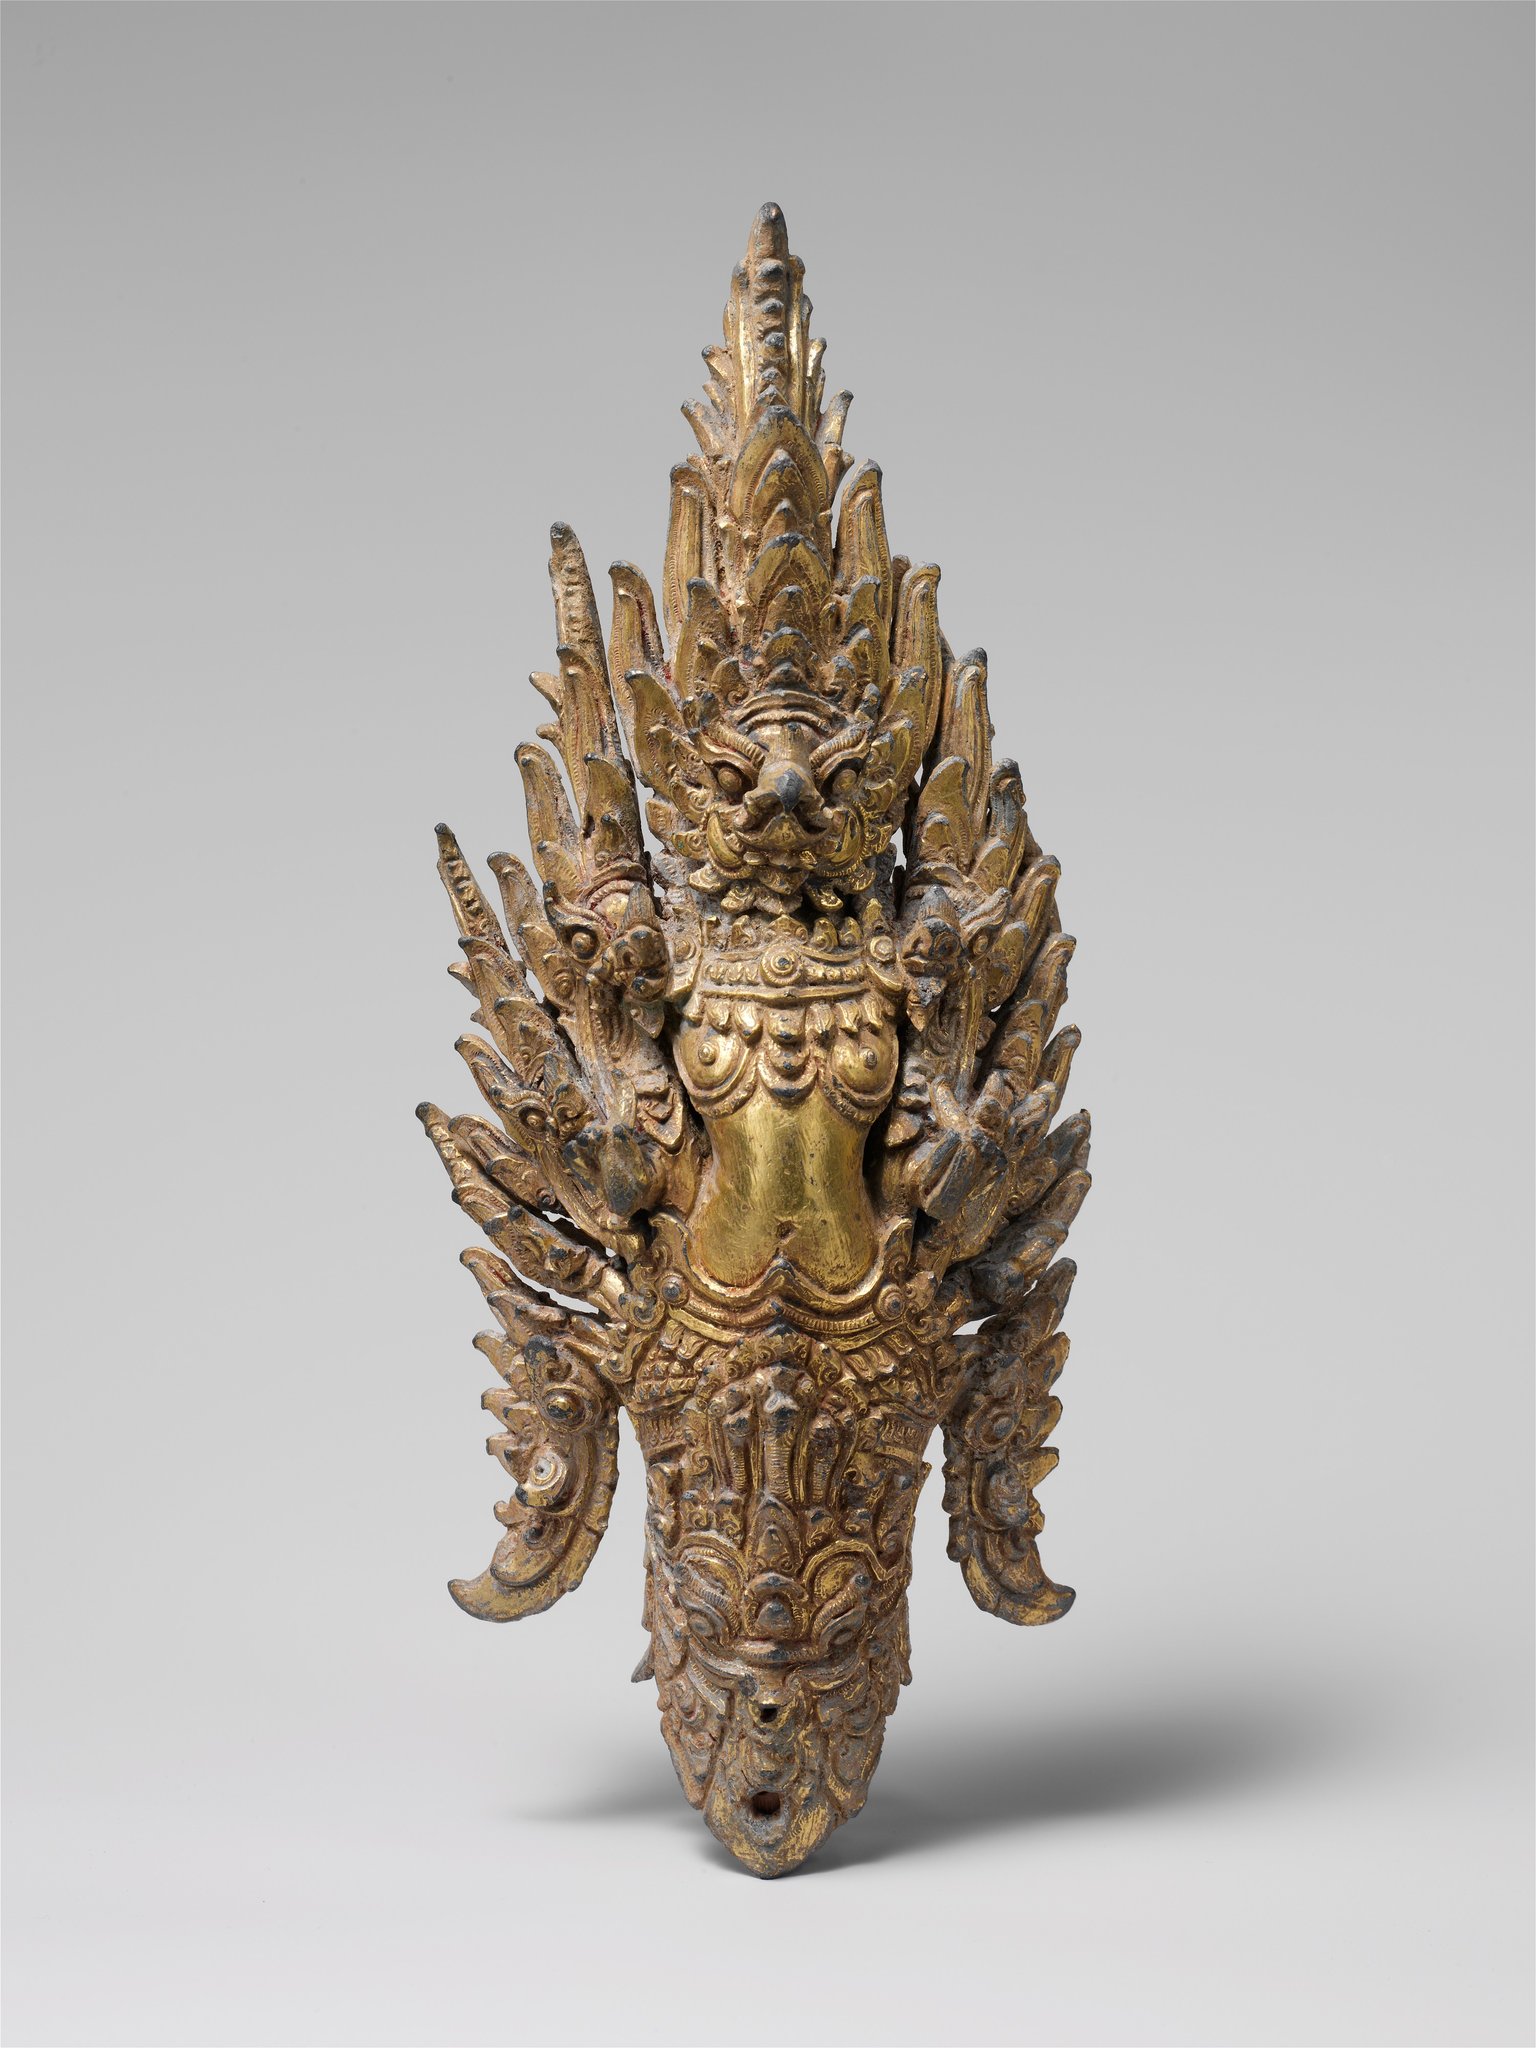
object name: garuda finial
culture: thai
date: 1167-1233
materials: gilt bronze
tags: mythical creatures,hinduism